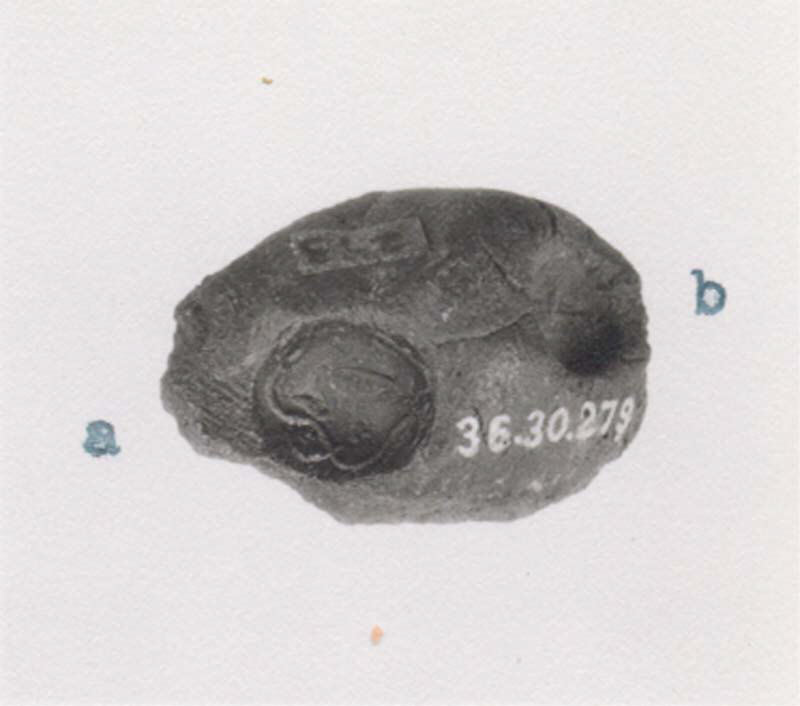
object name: sealing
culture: sasanian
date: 601-700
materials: clay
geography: iran